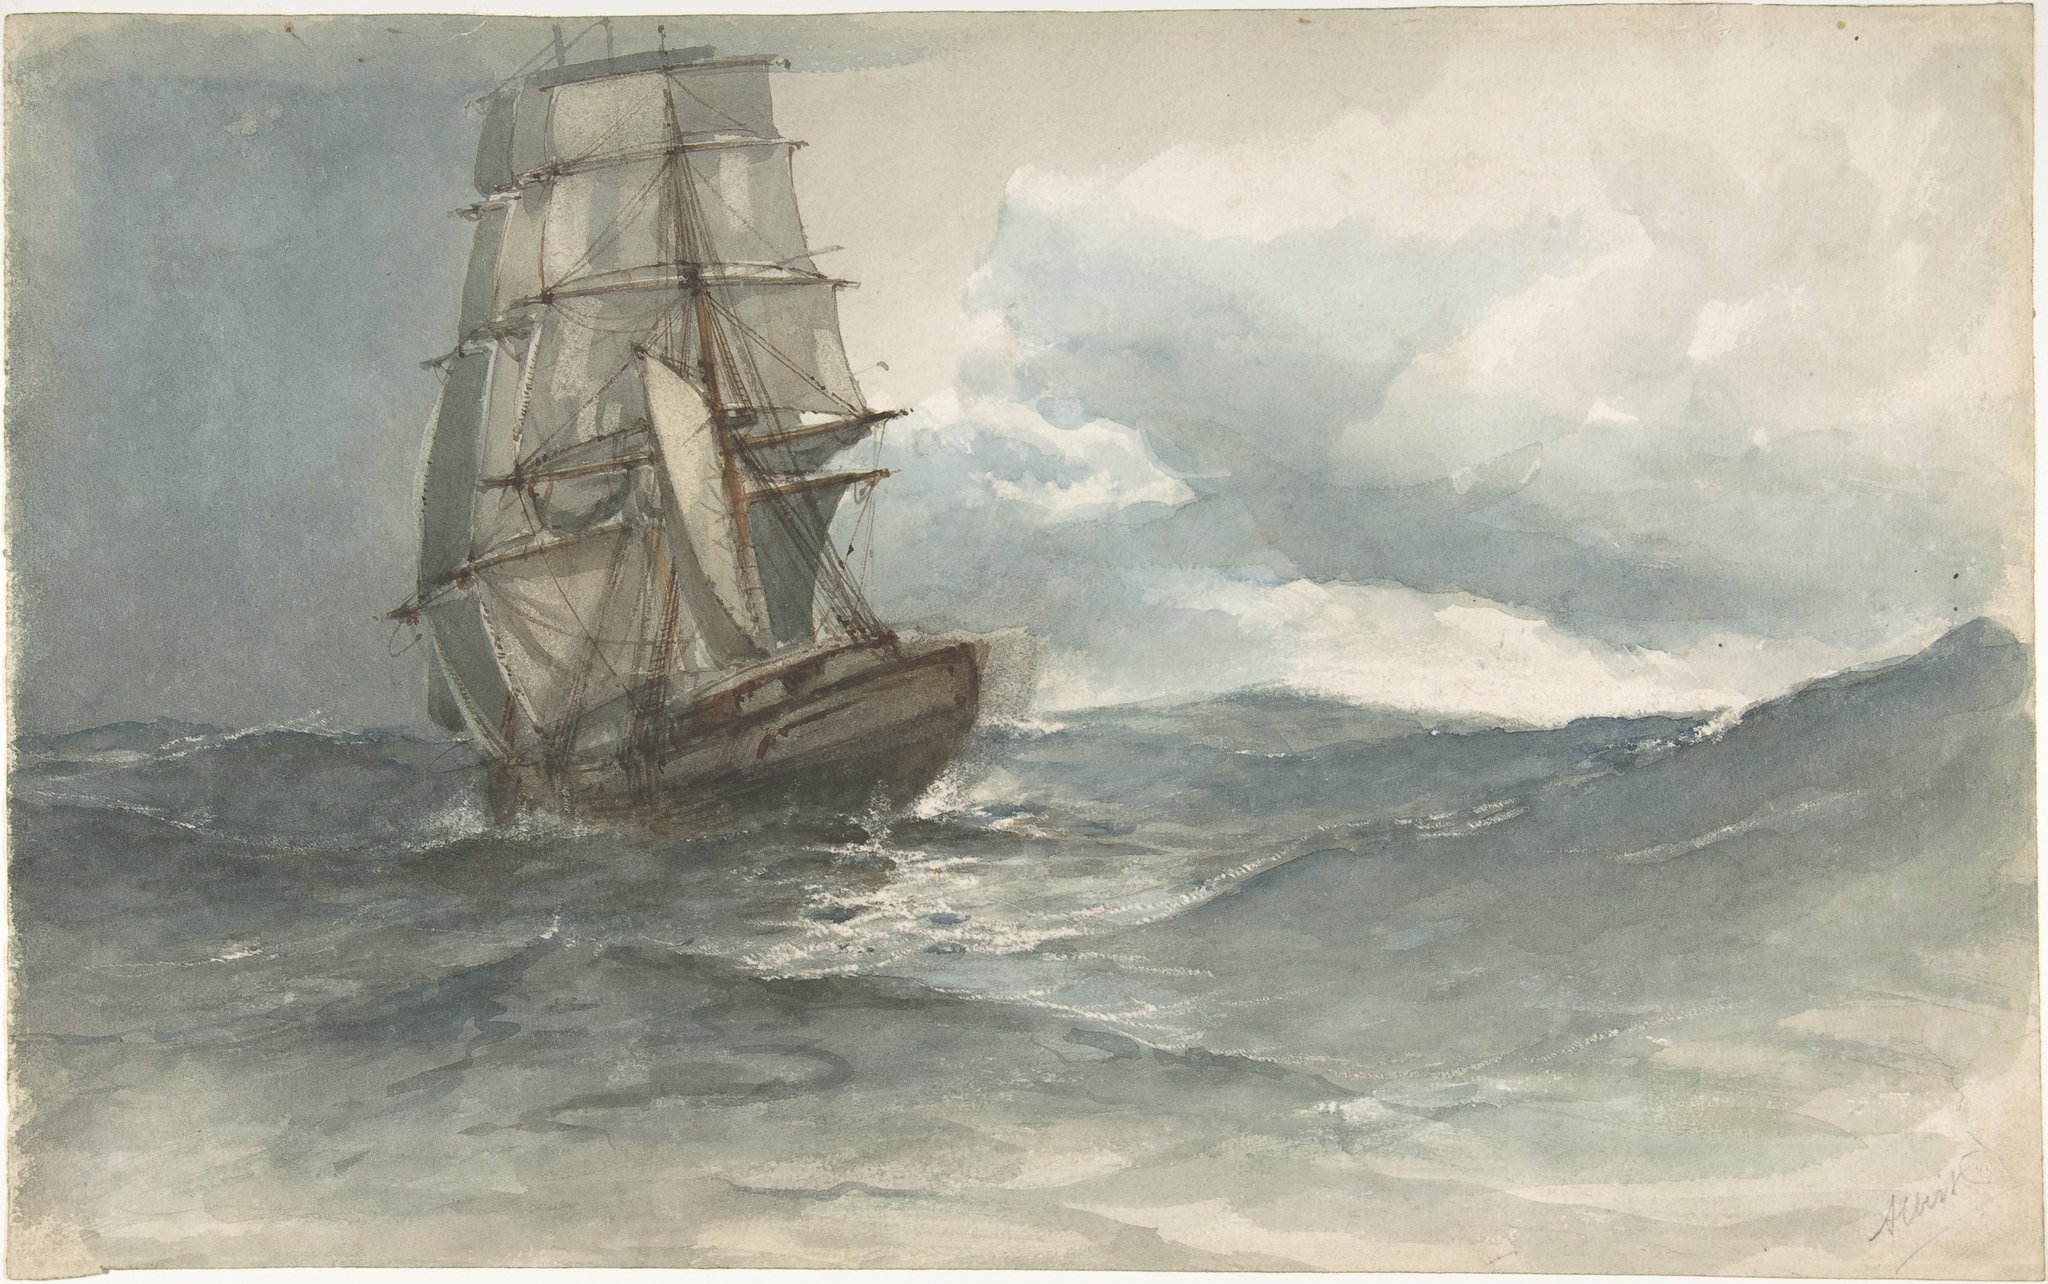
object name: drawing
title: Ship at Sea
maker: albert ernest markes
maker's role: artist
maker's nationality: british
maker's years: 1865-1901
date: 1867-1900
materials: watercolor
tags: seas,seascapes,ships